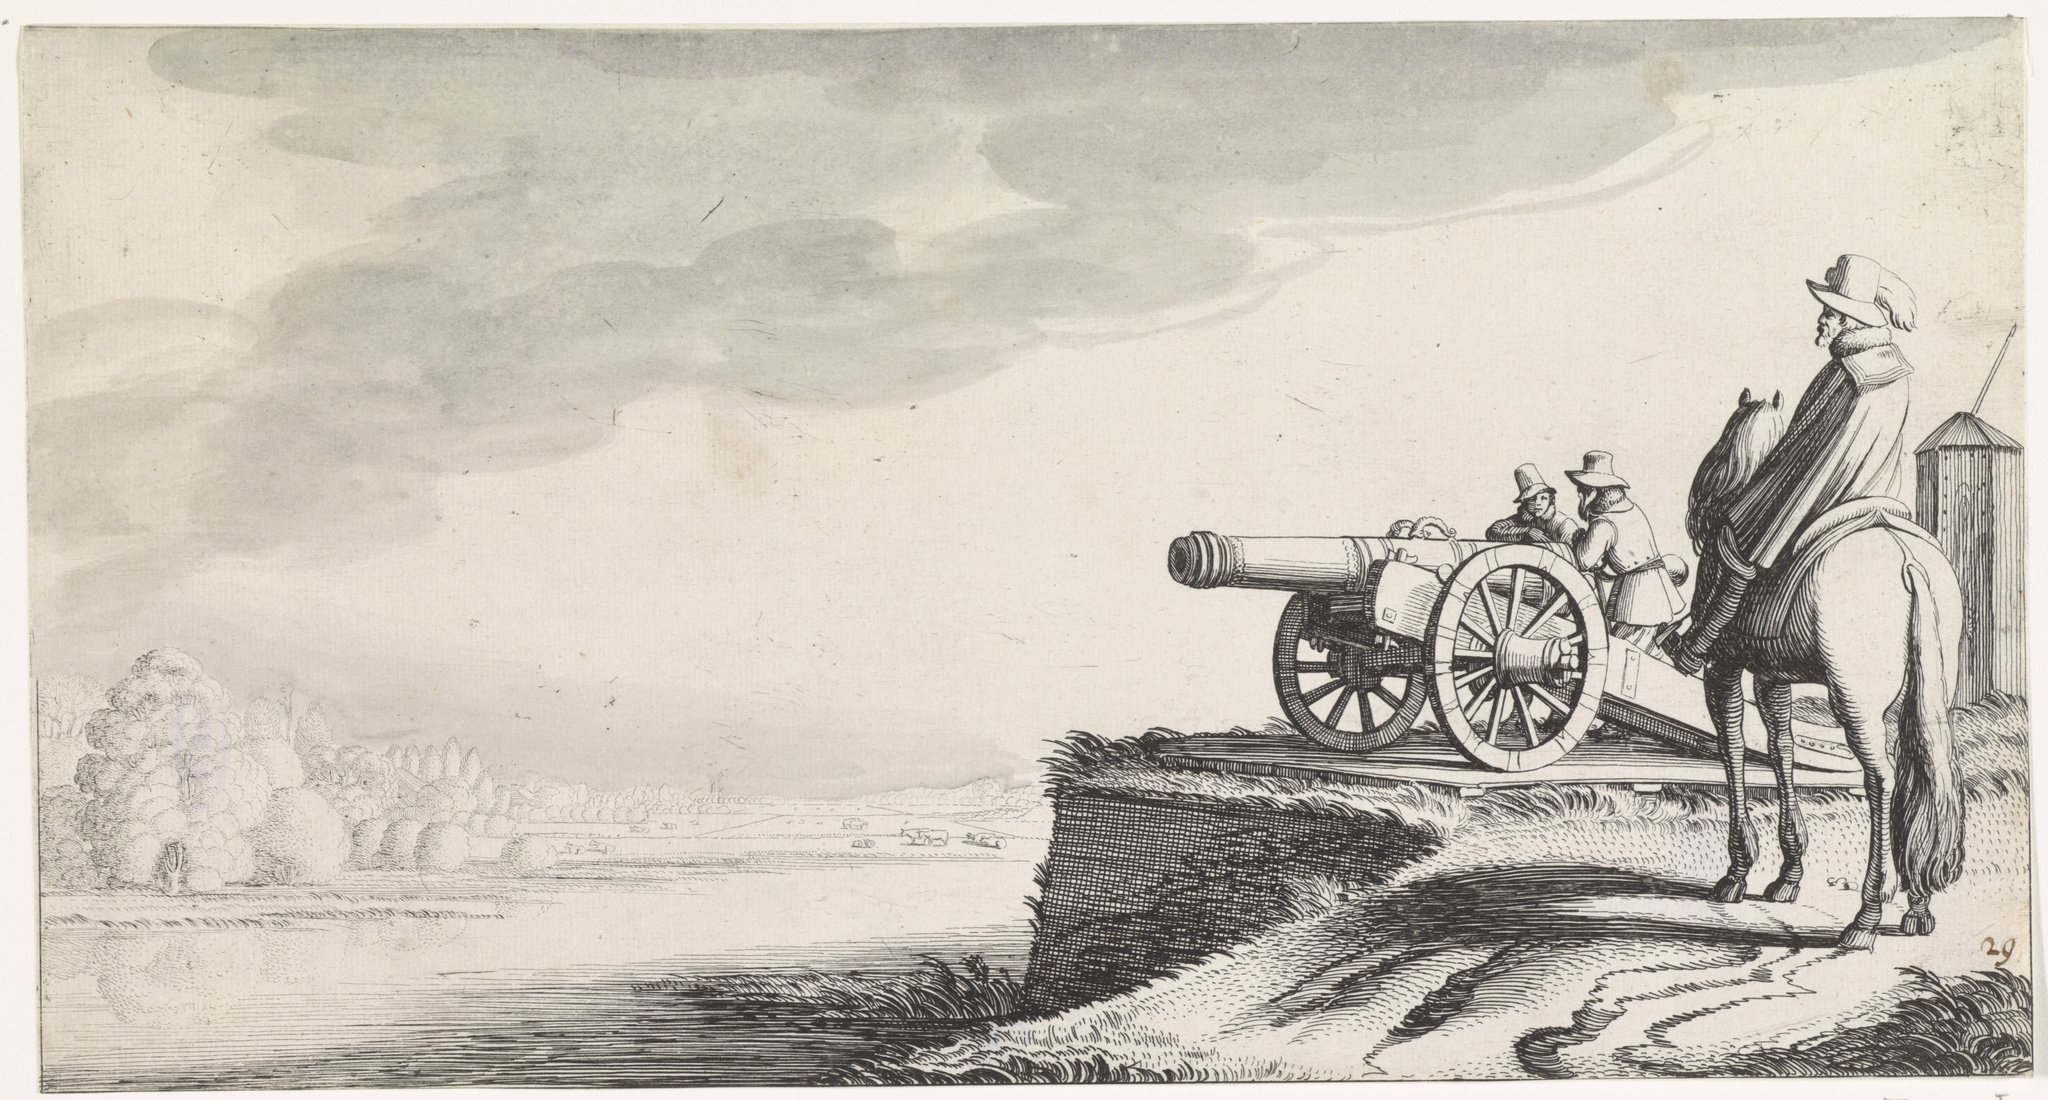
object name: print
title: Ruiter en twee soldaten bij een kanon op een rivieroever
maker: jan van de velde (ii)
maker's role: draughtsman, painter, print maker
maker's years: 1593-1641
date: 1639-1641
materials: ink, paper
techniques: brush, etching, pen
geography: northern netherlands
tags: riding a horse, ass, or mule; rider, horseman, river, firearms: cannon, the soldier; the soldier's life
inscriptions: number: ‘29’, collector's mark: Lugt 1120, collector's mark: Lugt 2228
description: Een ruiter en twee soldaten bij een kanon op een rivieroever. 29ste prent van een serie met 36 prenten van landschappen, verdeeld over zes delen.